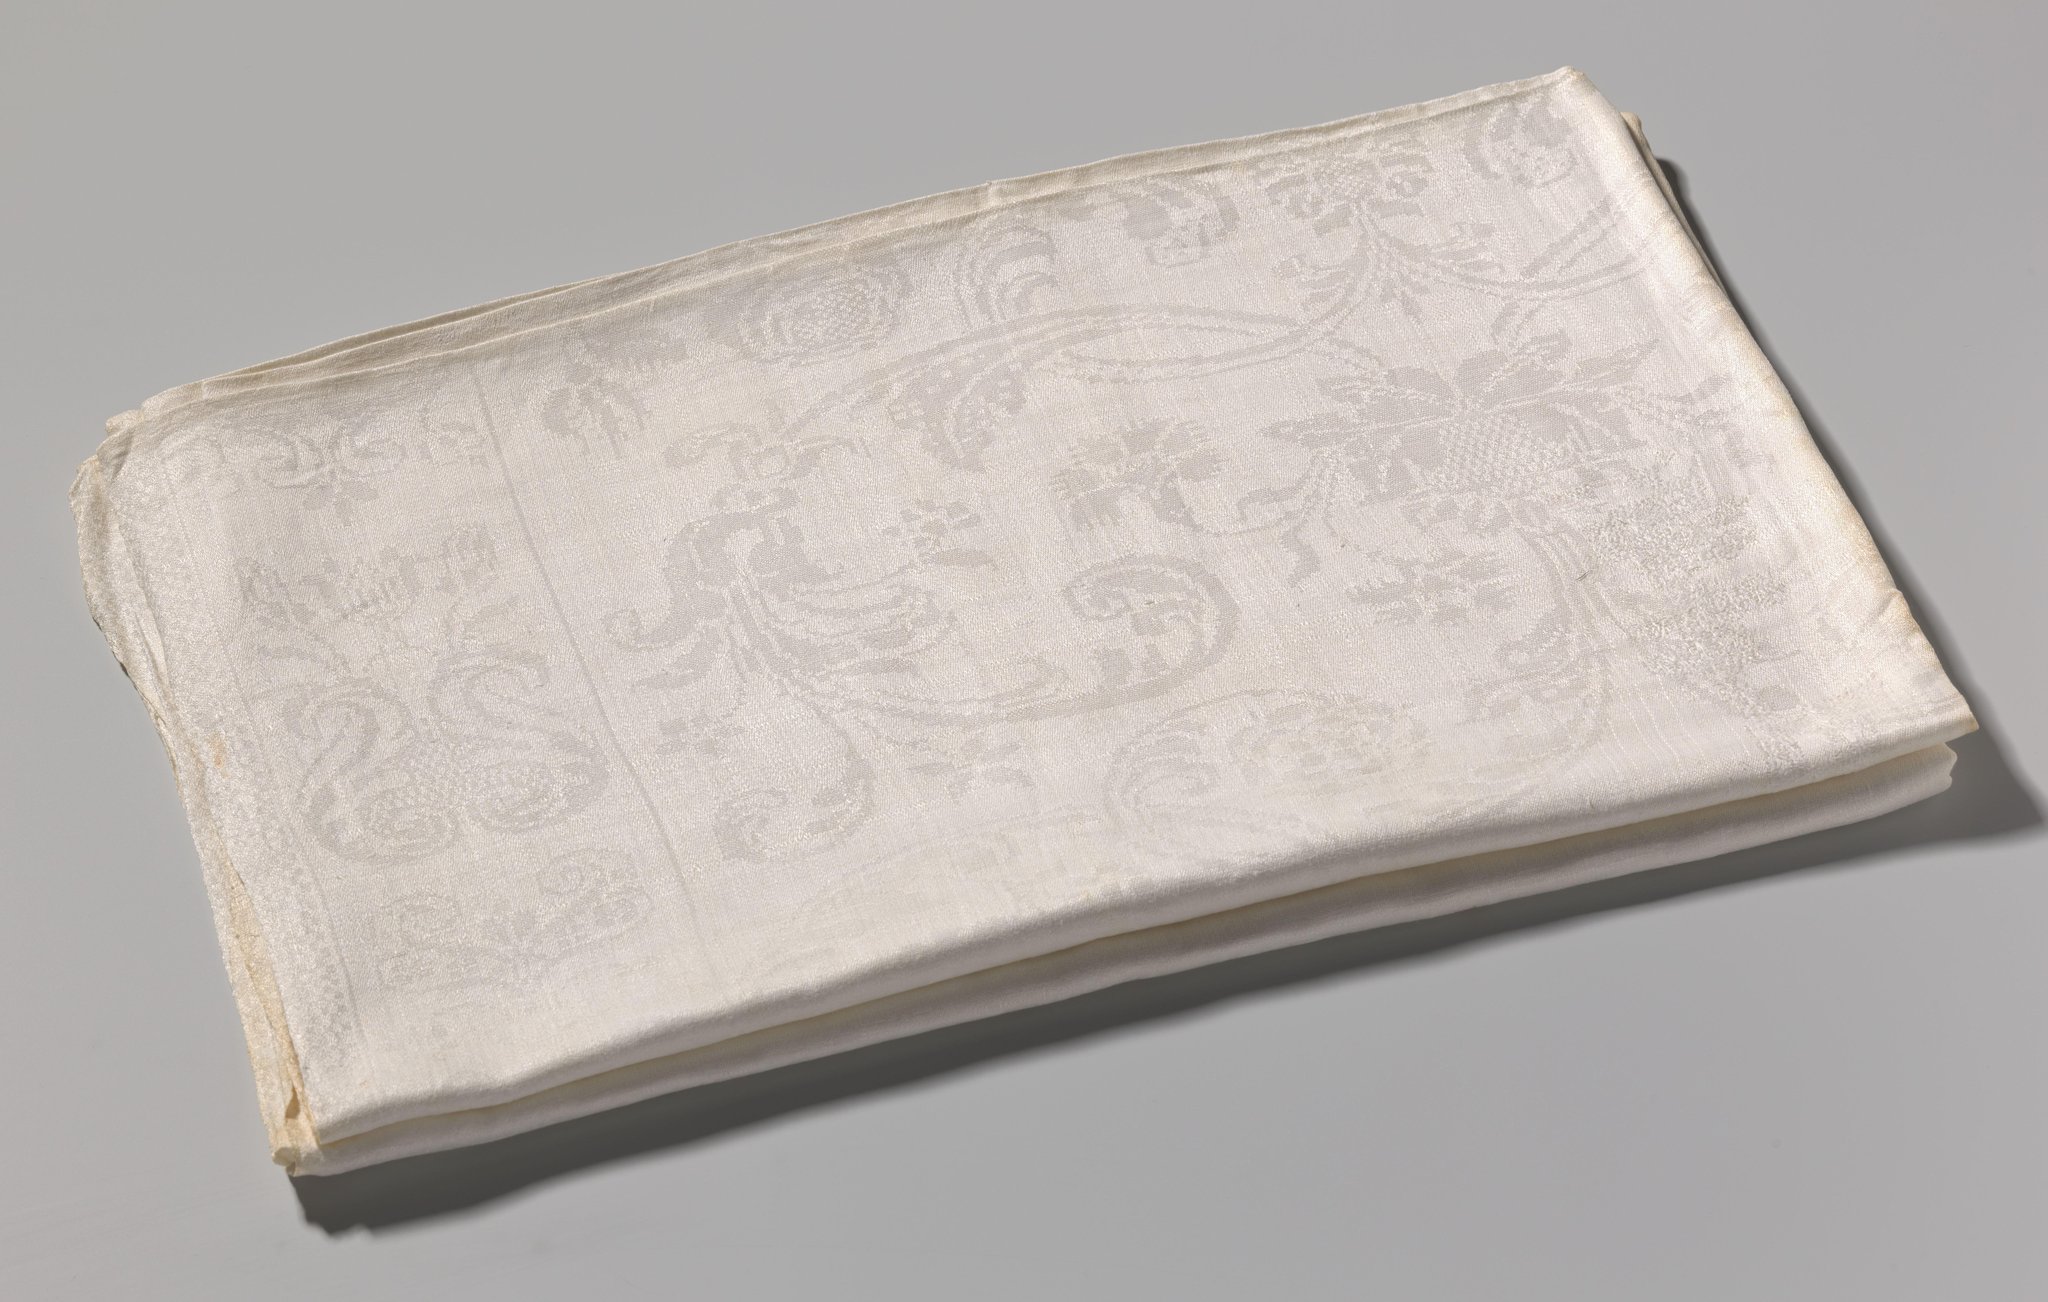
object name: tablecloth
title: Tafellaken van linnendamast met een bloempatroon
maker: Anonymous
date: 1675-1700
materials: linen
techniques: damask, weave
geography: flanders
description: Tafellaken van linnendamast met bloemen en bladvoluten.